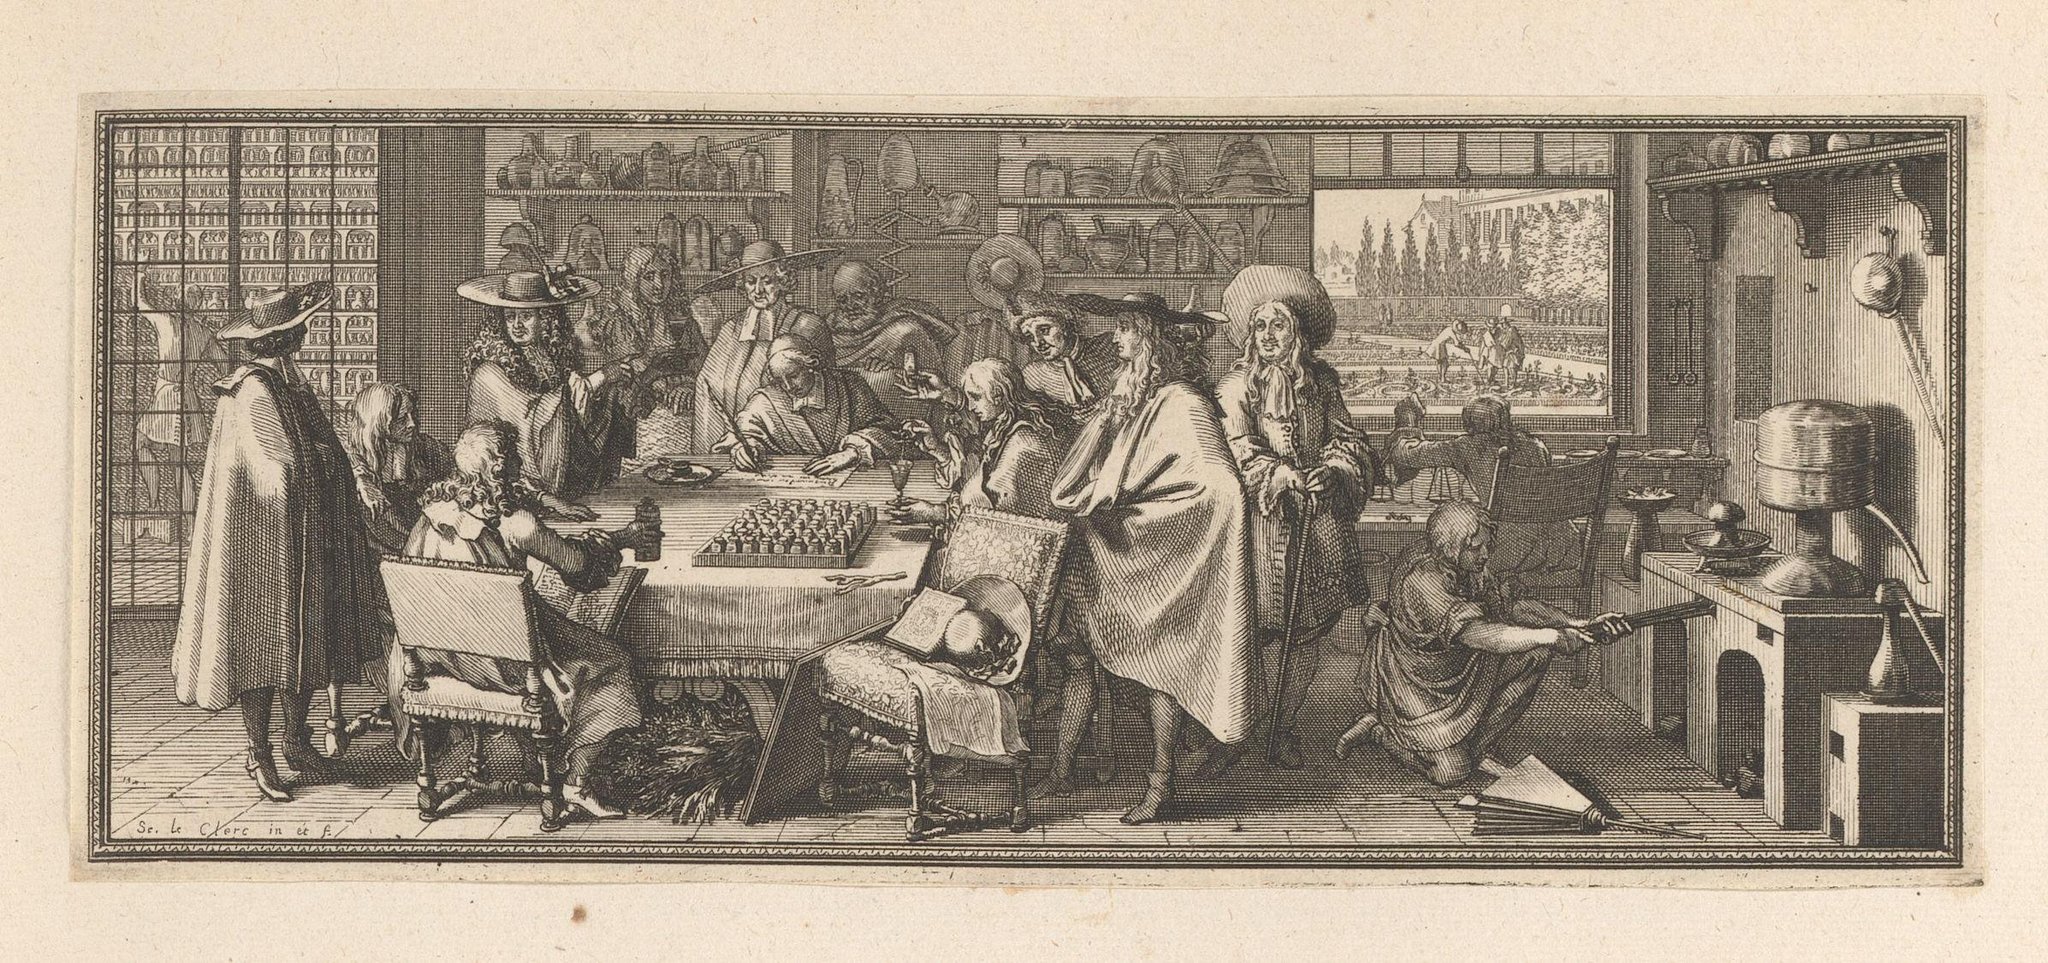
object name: book illustration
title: Vignet met verschillende geleerden rond een tafel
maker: sébastien leclerc (i)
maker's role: print maker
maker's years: 1637-1714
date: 1676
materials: paper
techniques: etching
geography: paris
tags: group of scholars or philosophers, vignette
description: Prent uit: Dodart, Denis. Mémoires pour servir à l'histoire des plantes (...).. Parijs: Imprimerie Royale, 1676. Vignet gebruikt voor: 'Projet de l'Histoire des plantes'.